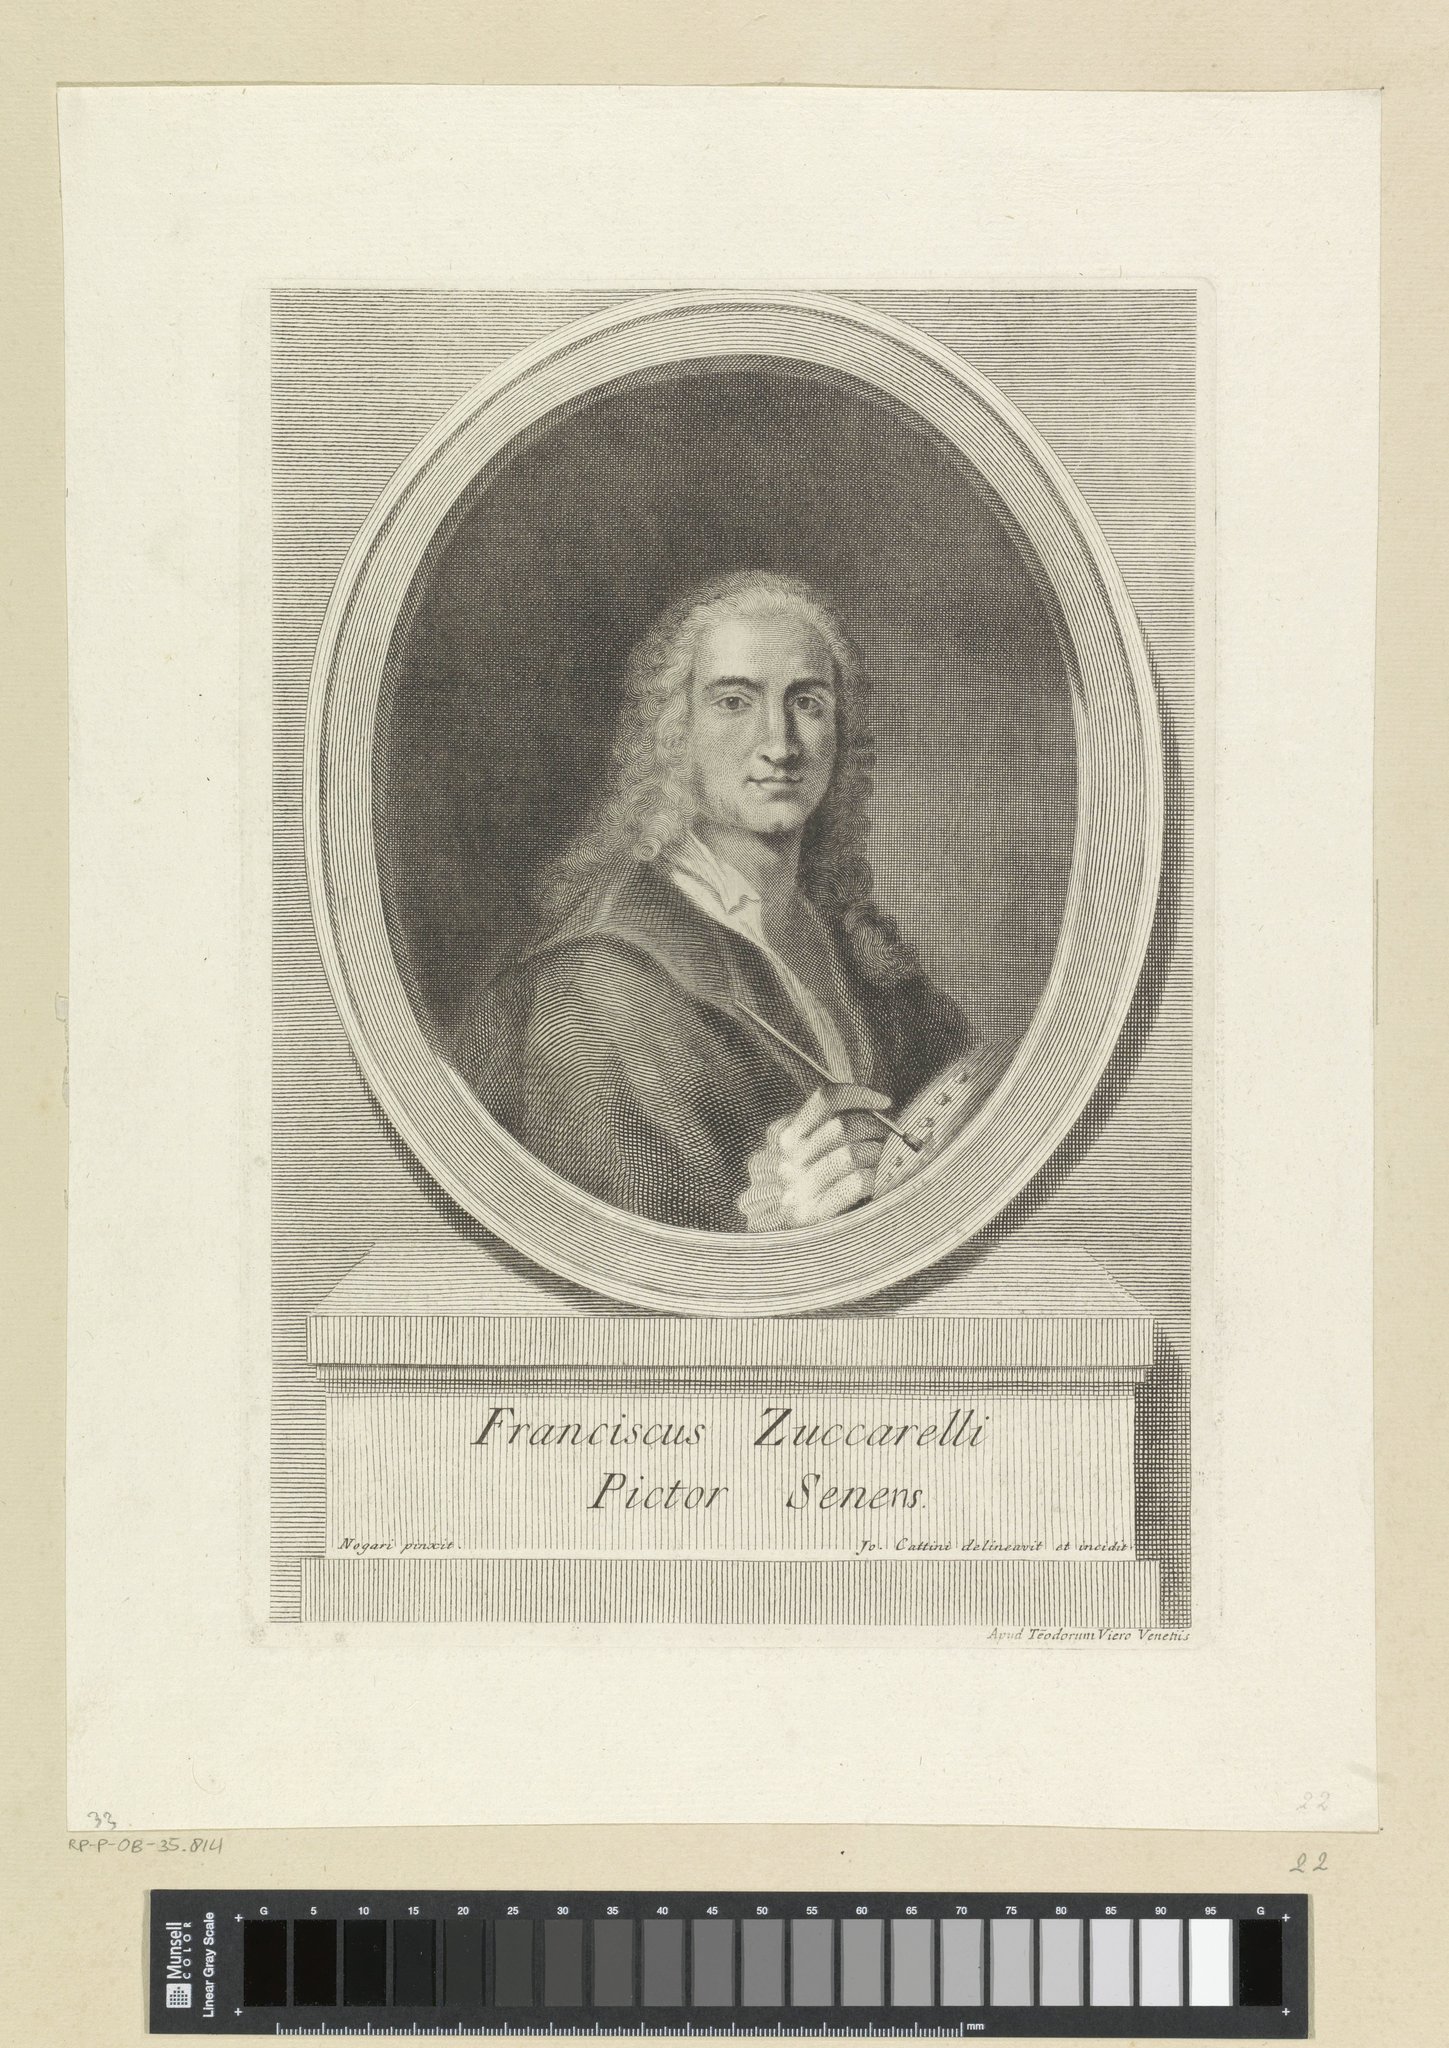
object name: print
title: Portret van schilder Francesco Zuccarelli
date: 1735-1800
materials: paper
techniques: engraving, etching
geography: italy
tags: pitigliano, painter, draughtsman, francesco zuccarelli, historical persons, portrait, self-portrait of artist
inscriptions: collector's mark: Lugt 240